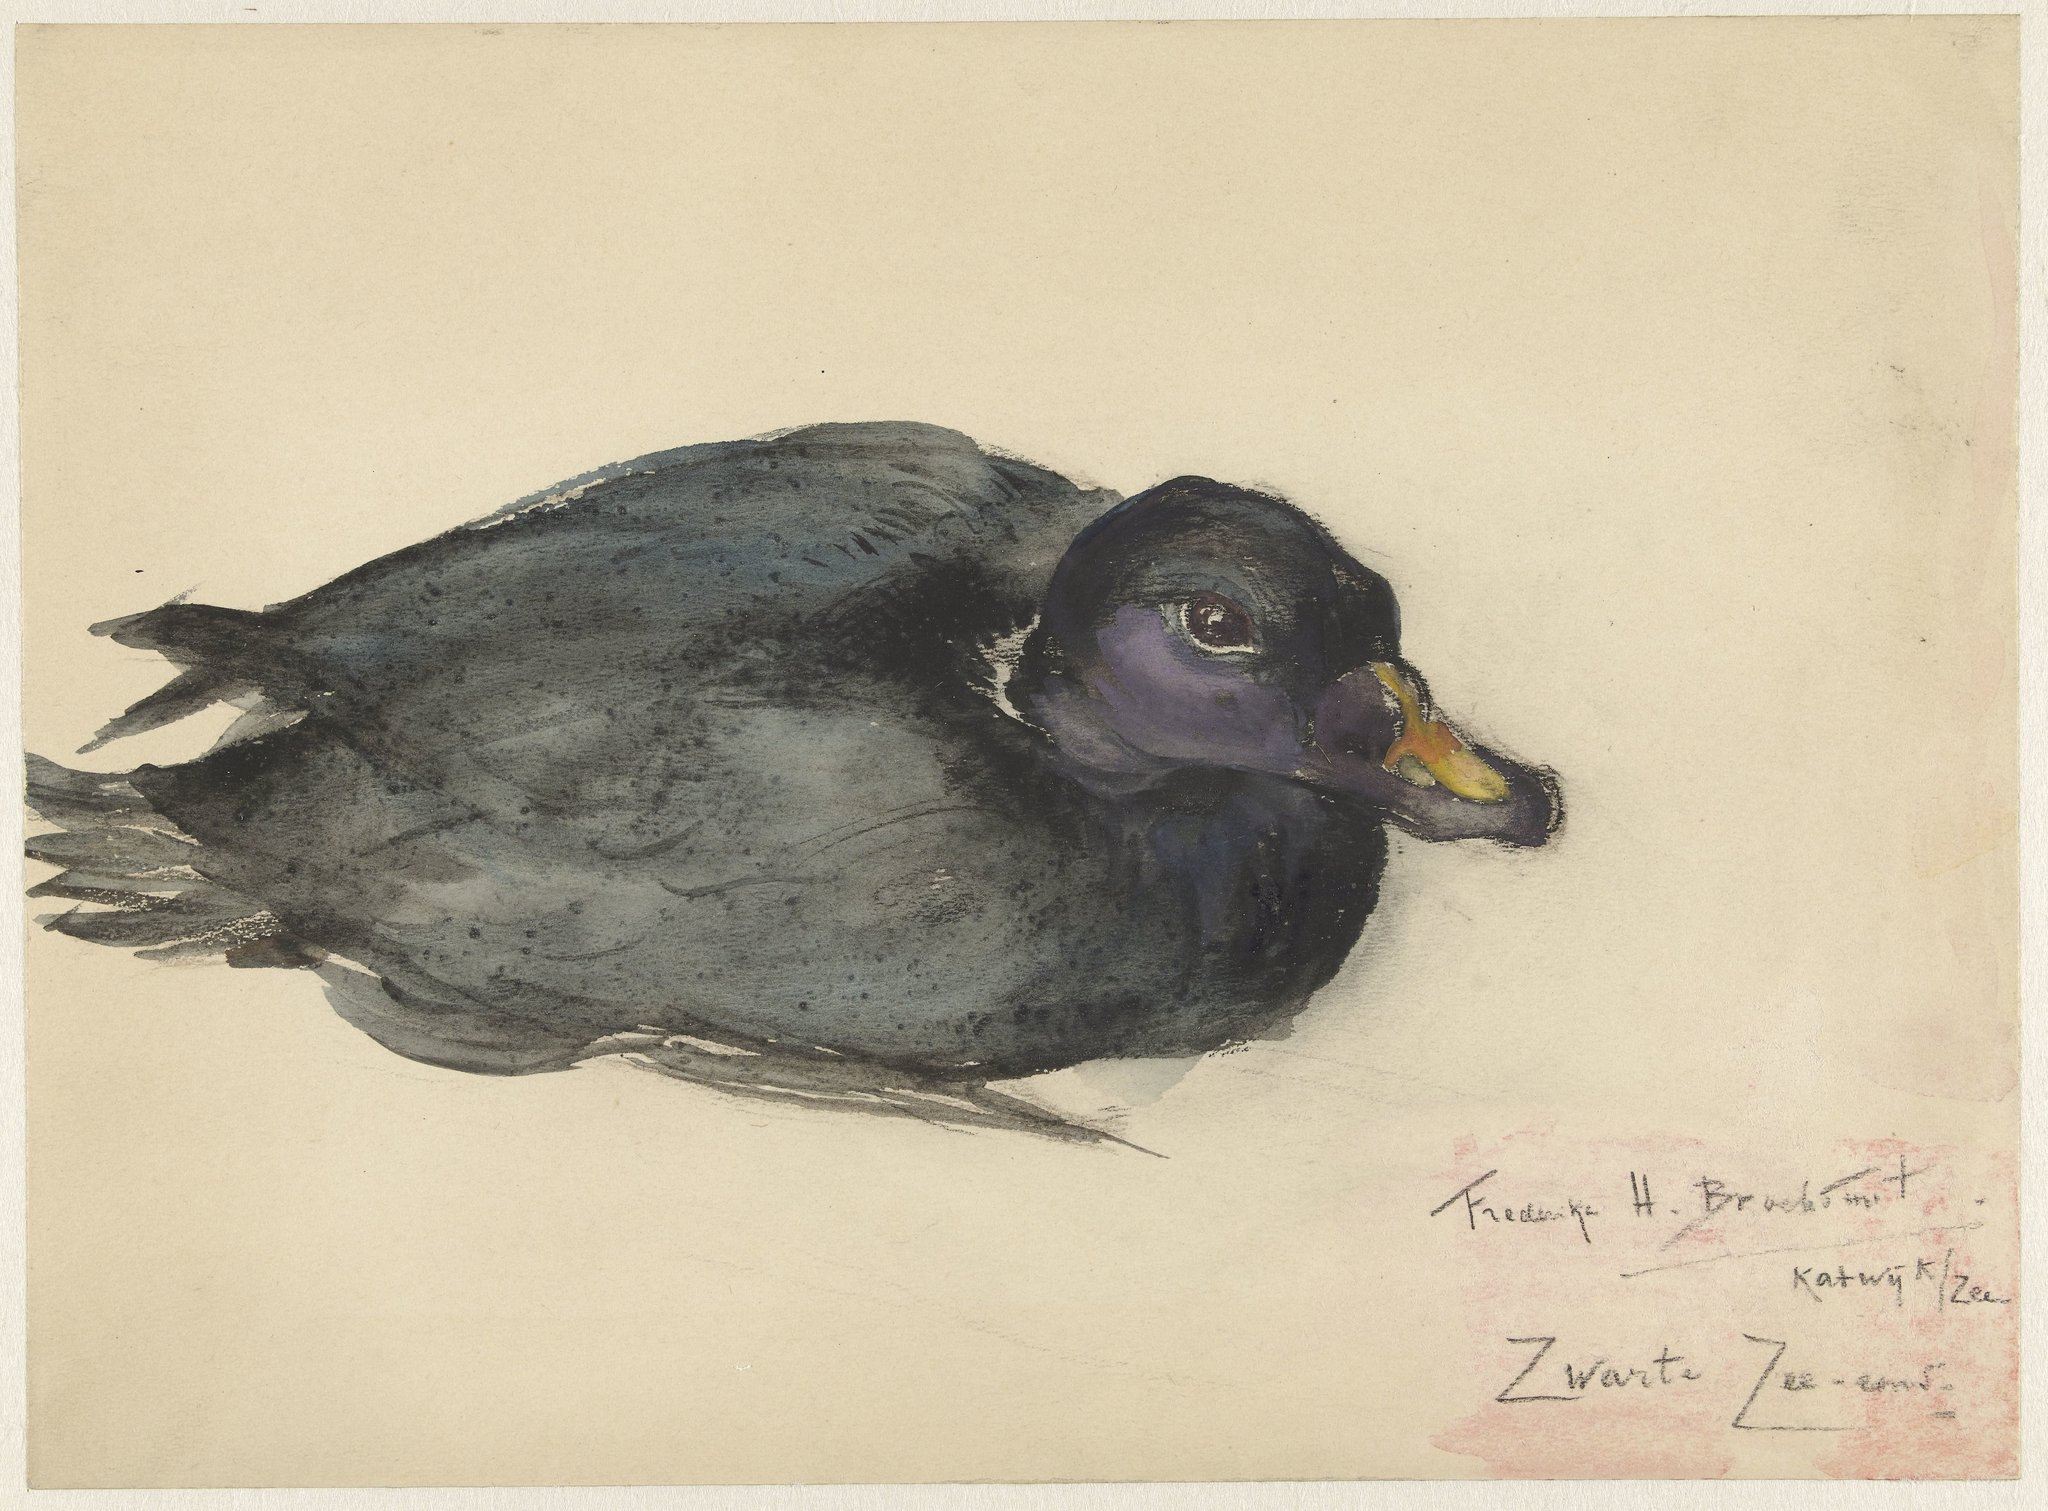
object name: drawing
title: Zwarte zee-eend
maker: frederika henriëtte broeksmit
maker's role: draughtsman, print maker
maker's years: 1875-1945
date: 1885-1931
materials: chalk, paper, watercolor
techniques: brush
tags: water-birds: scoter, water-birds: duck